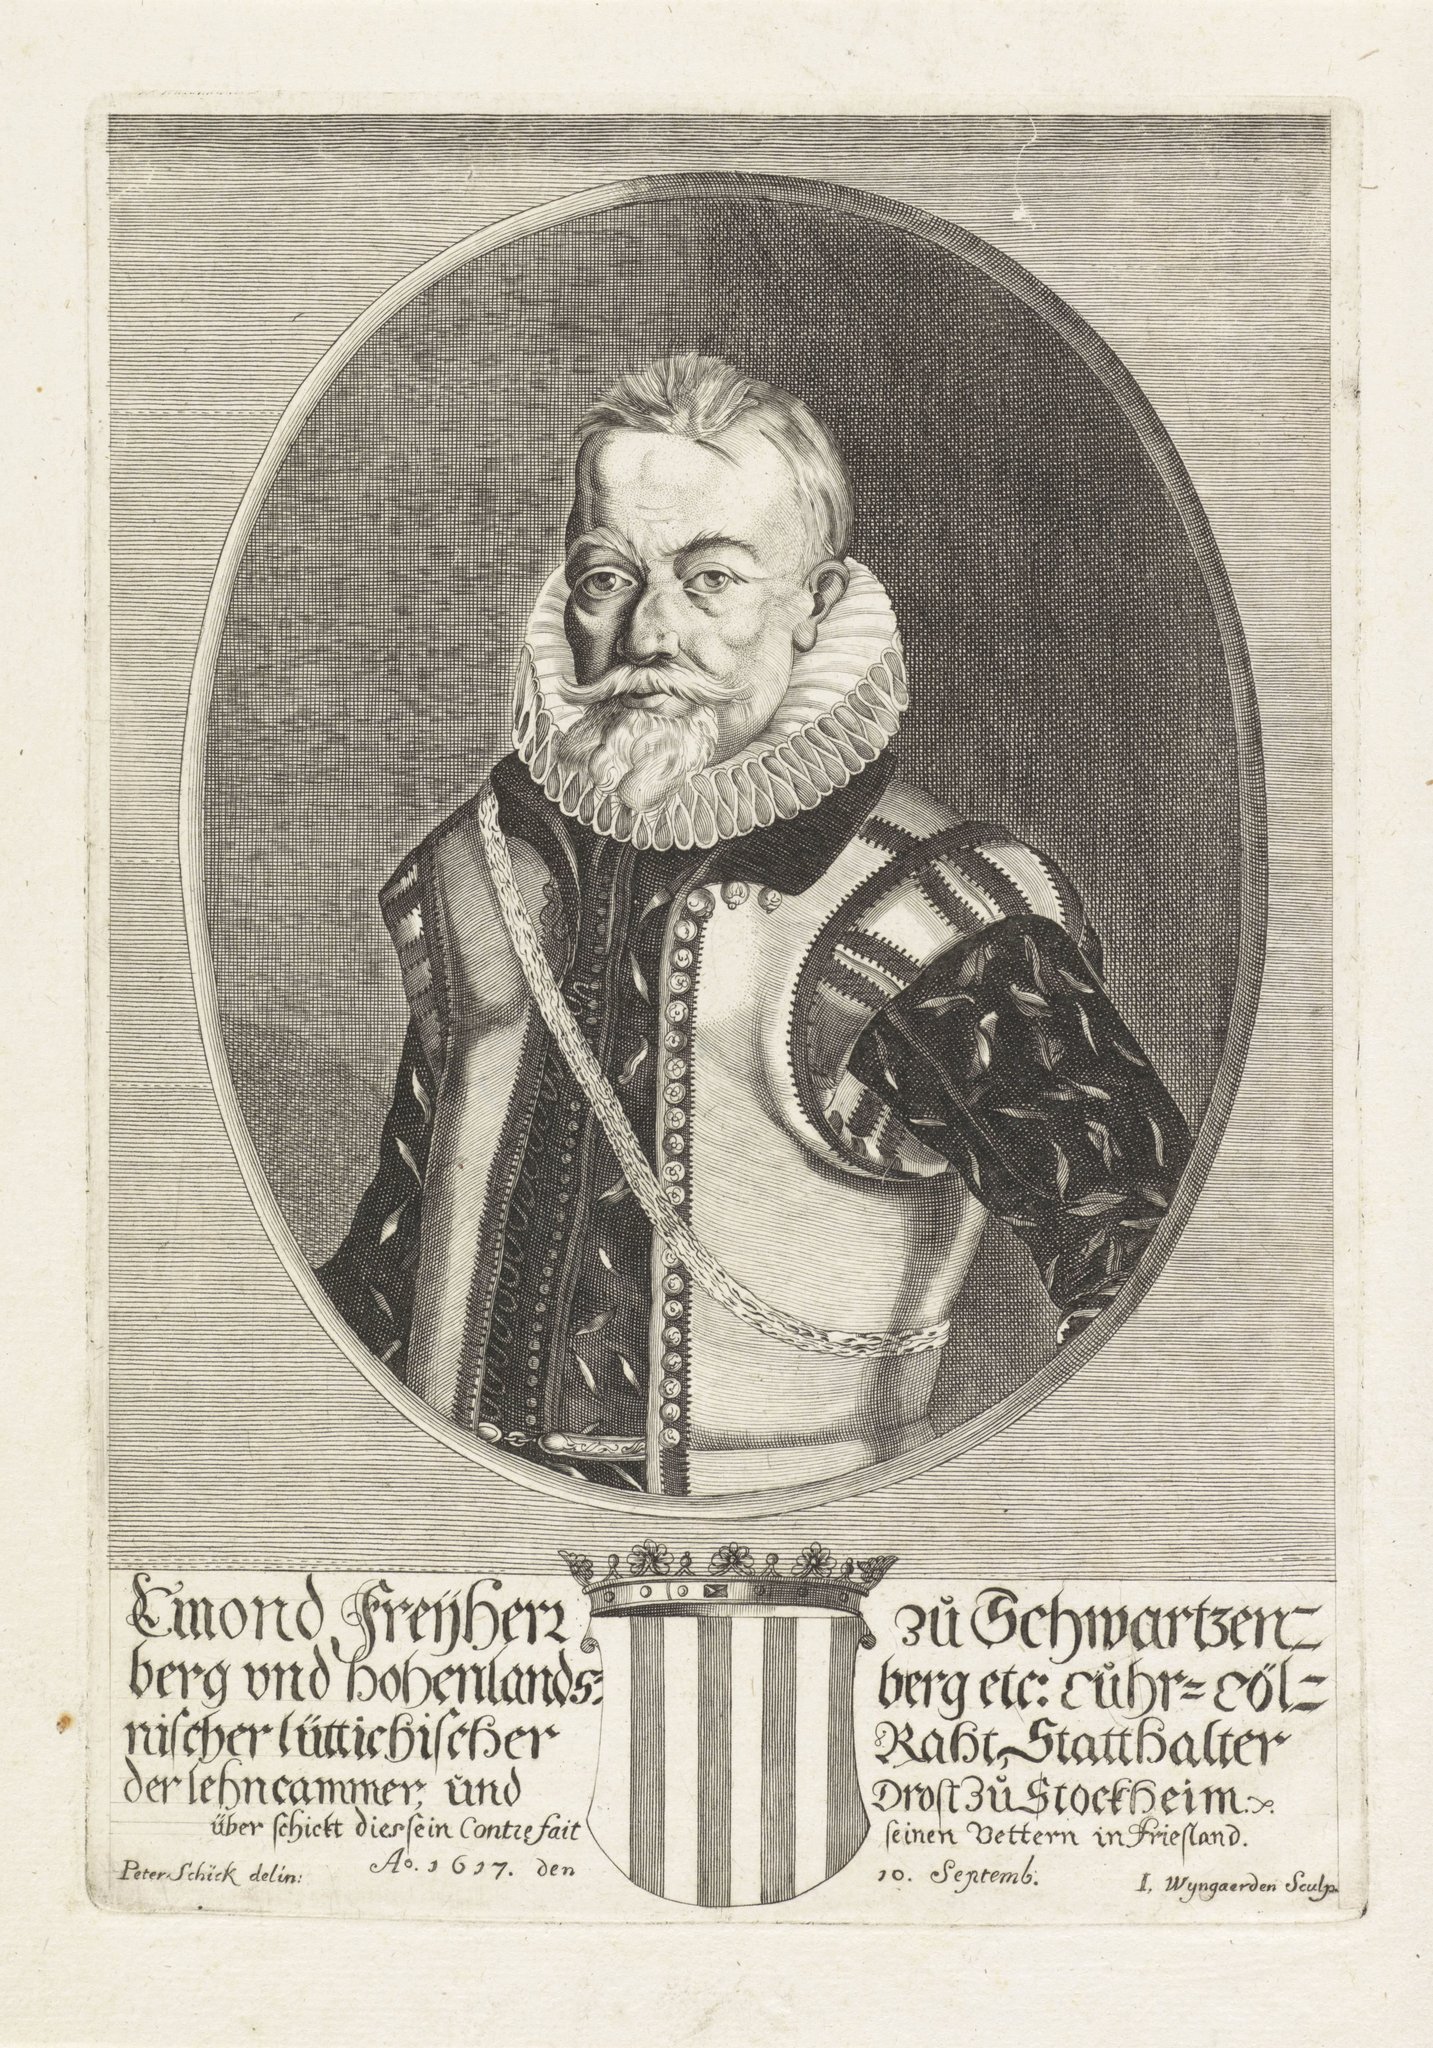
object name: print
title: Portret van Edmund (II) Schwartzenberg-Hohenlandsberg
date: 1617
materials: paper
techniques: engraving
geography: northern netherlands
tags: armorial bearing, heraldry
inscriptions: collector's mark: Lugt 2228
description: Portret van Edmund (II) Schwartzenberg-Hohenlandsberg. In de marge diens wapenschild en een vijfregelig onderschrift in het Duits.